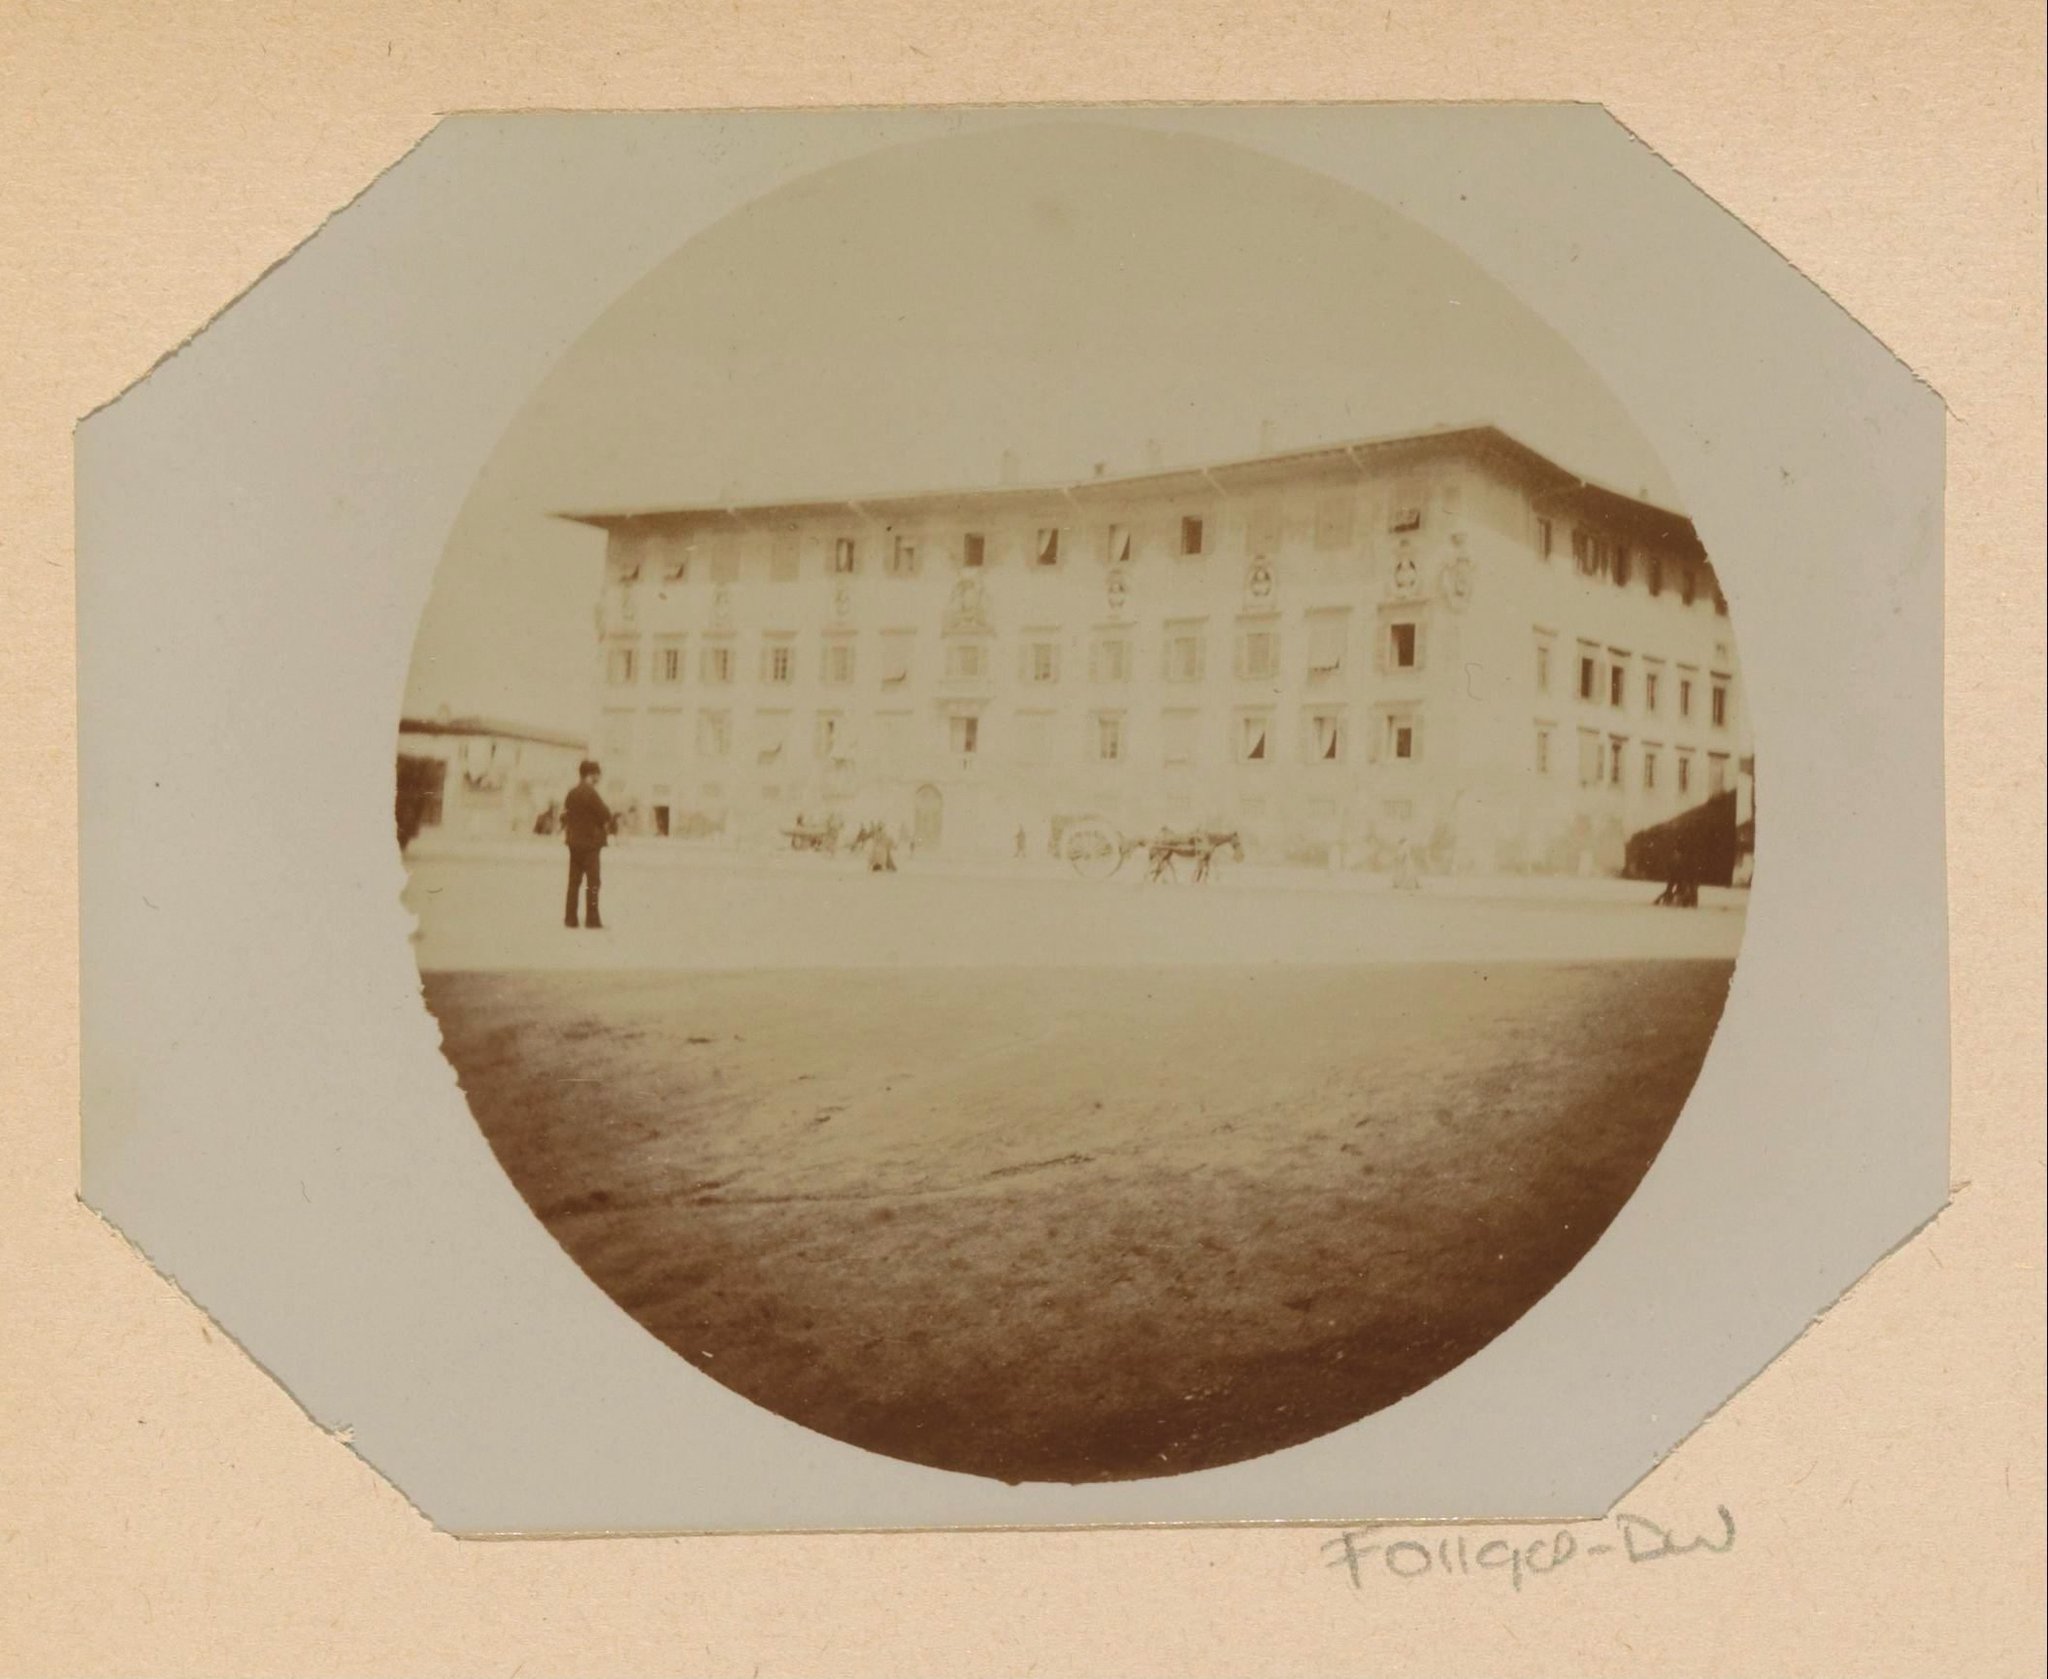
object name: album leaf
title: Pisa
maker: johanna margaretha piek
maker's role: fotograaf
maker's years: 1870-1947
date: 1889-1893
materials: paper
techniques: gelatin silver print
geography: pisa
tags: palace